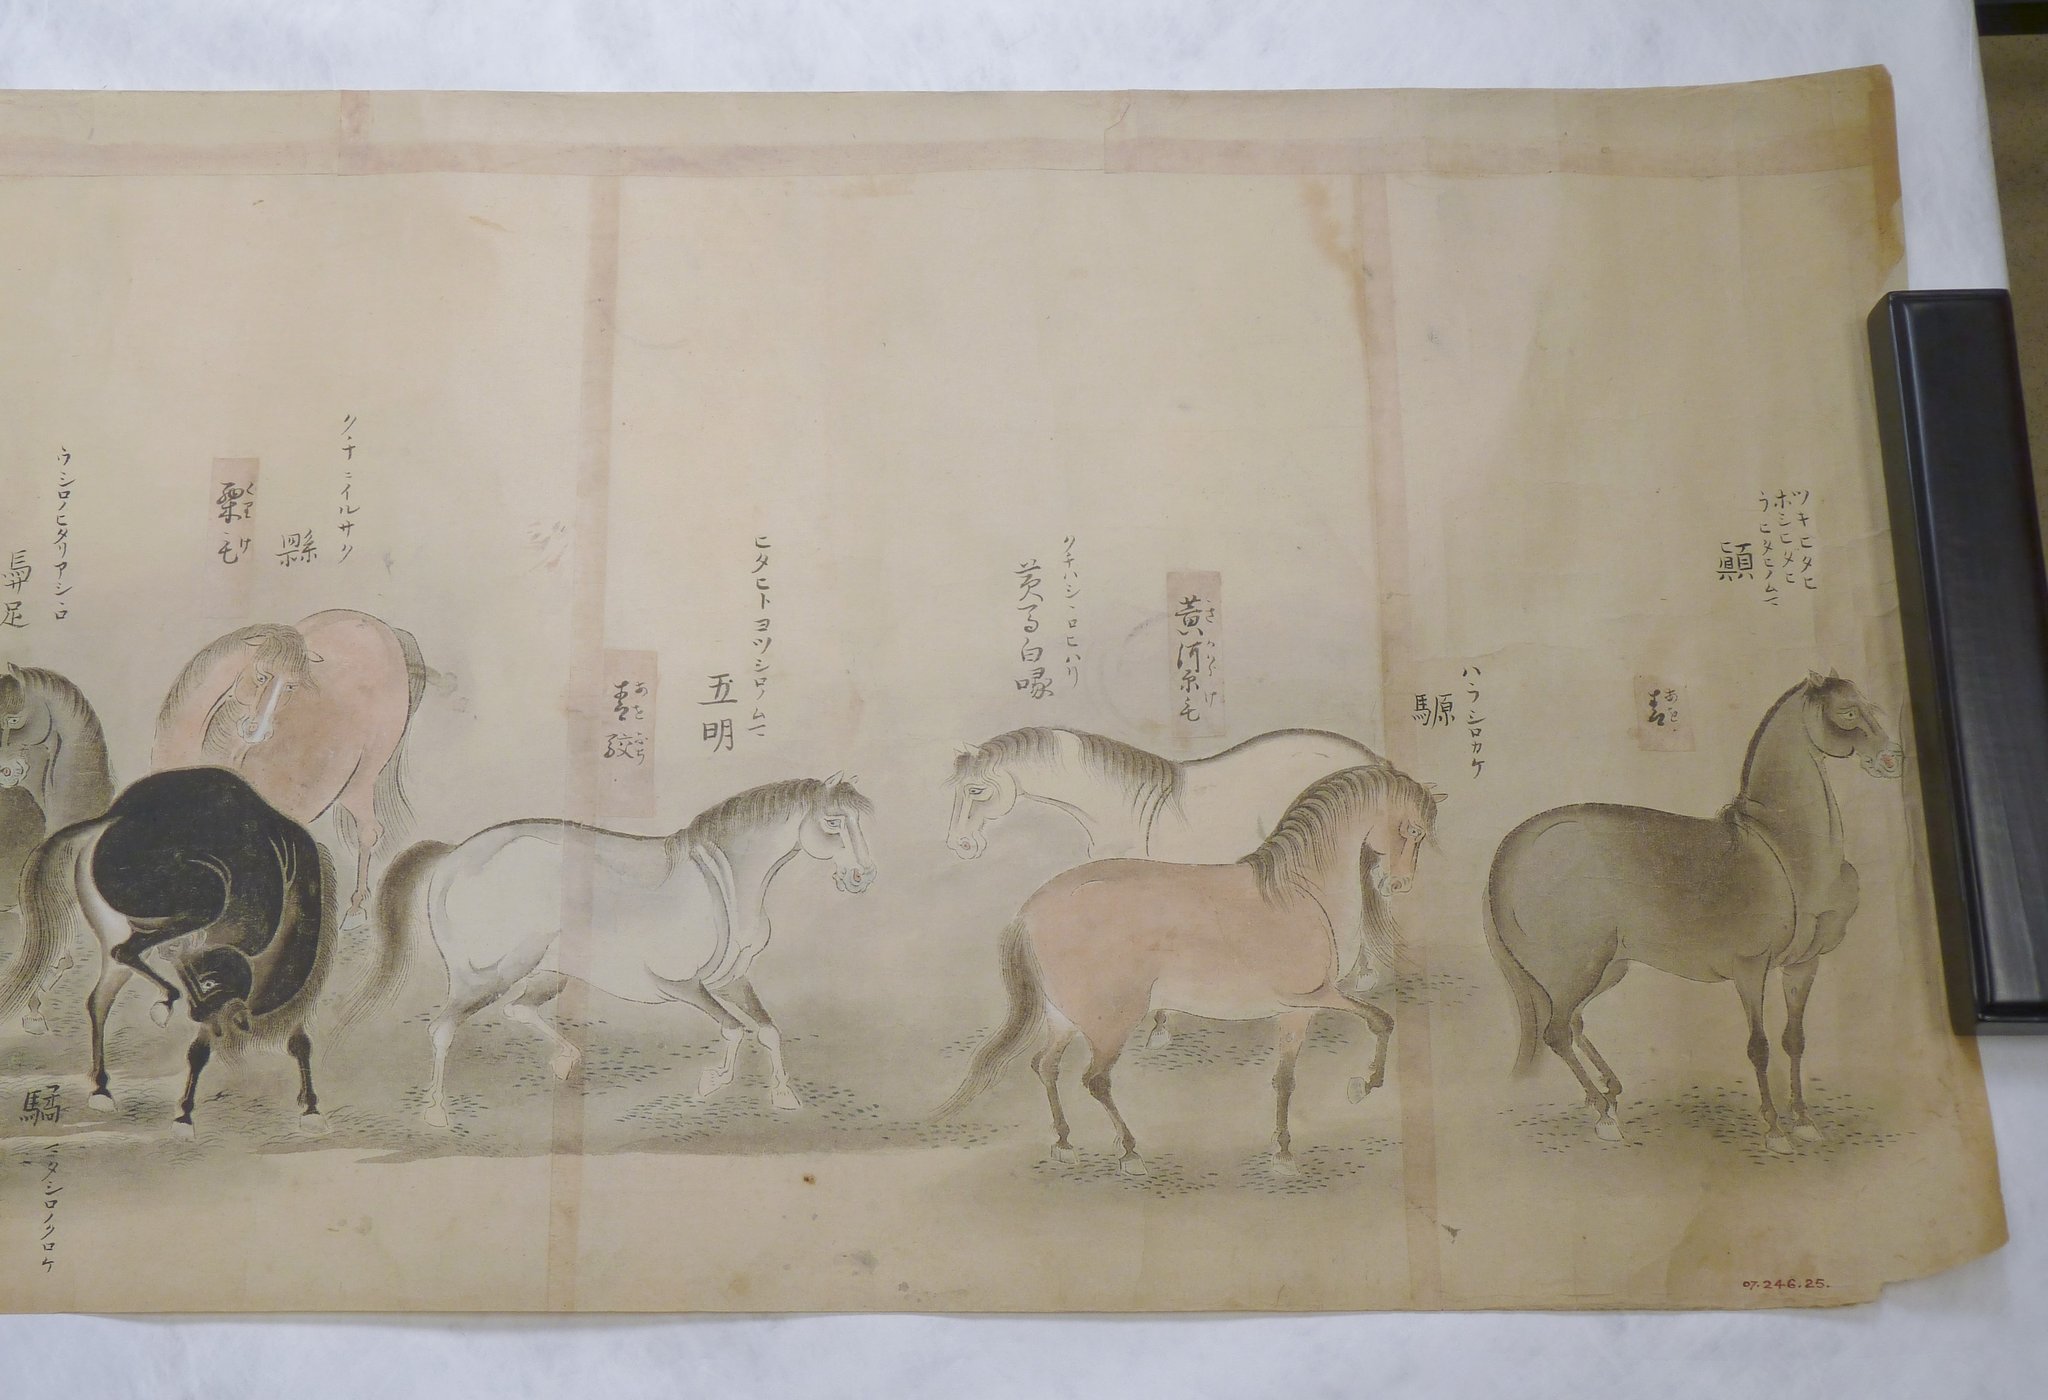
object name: drawing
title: Japanese Drawing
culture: japanese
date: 1801-1833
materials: paper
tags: horses